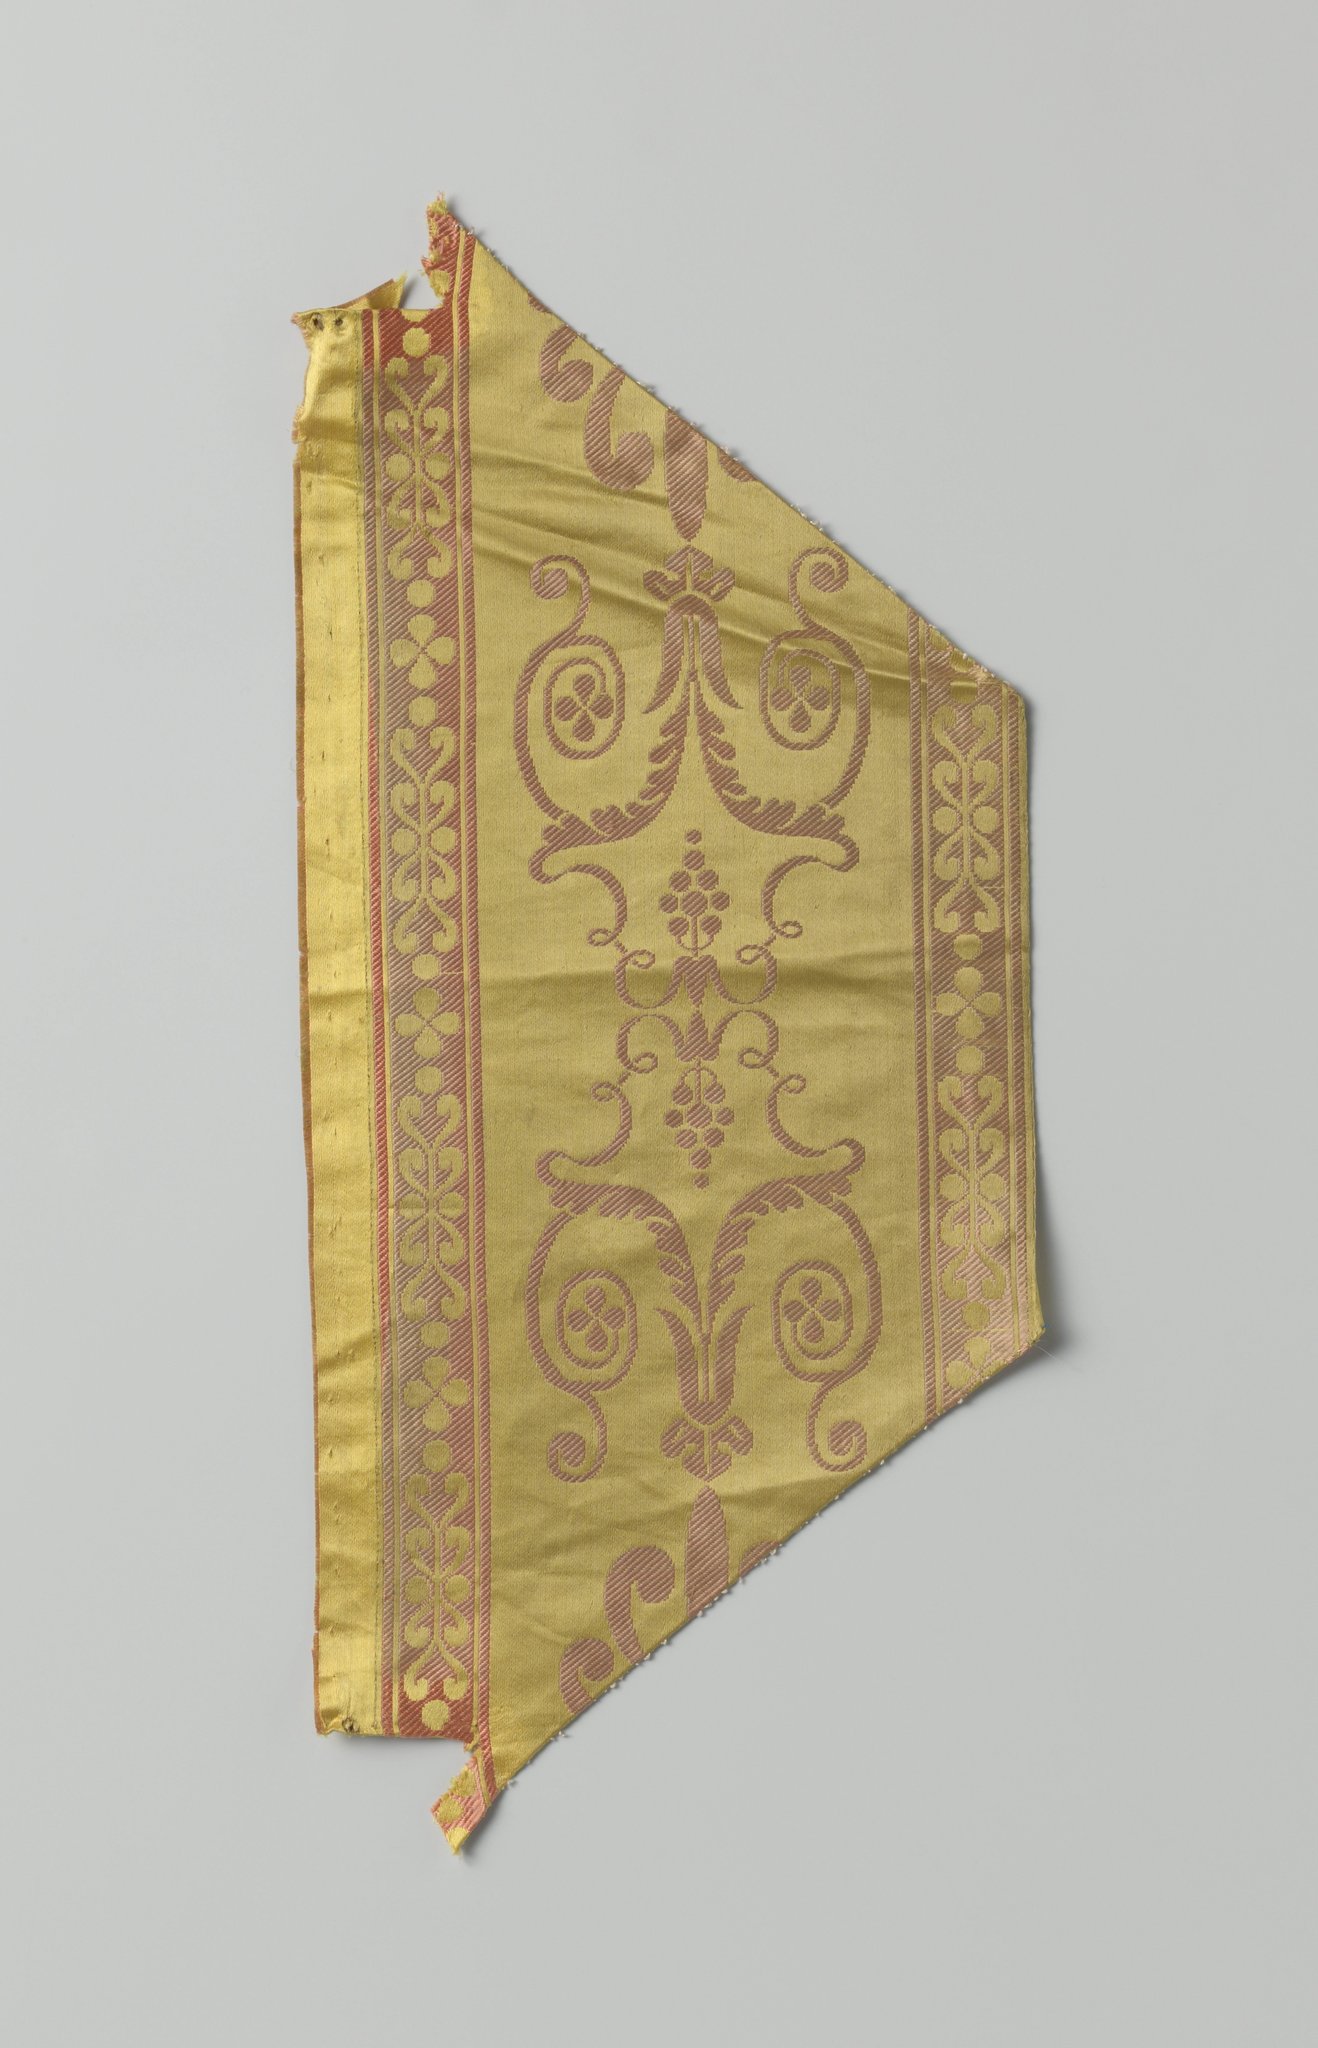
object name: stoelbekleding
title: Fragment zijdeweefsel van een stoelbekleding.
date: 1805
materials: silk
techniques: brocade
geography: france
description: Fragment geel zijdeweefsel, van een stoelbekleding. Het patroon heeft op een gele grond roze palmetten en arabesken. Het fragment hoort bij dertien fragmenten met invnr. BK-1992-18-A t/m BK-1992-18-M.